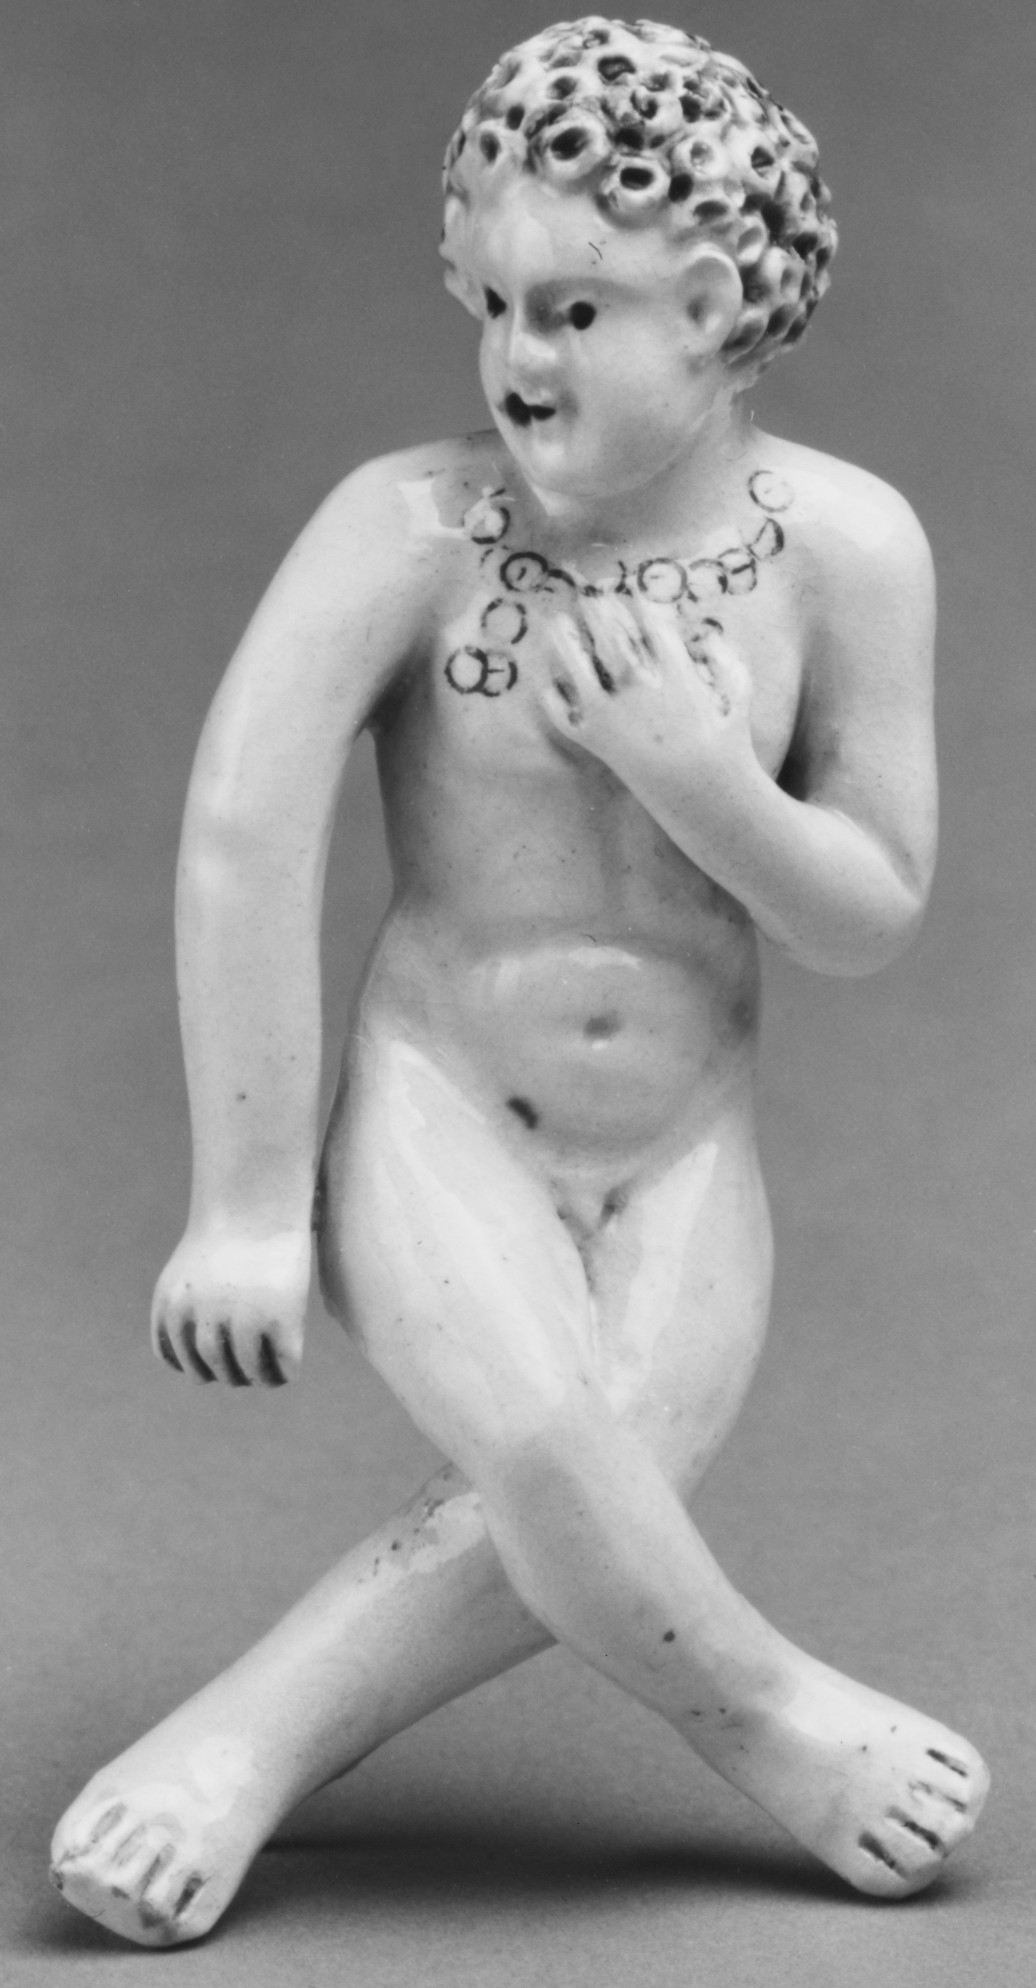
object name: figure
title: Putto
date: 1555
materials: pottery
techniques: glazing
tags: putti